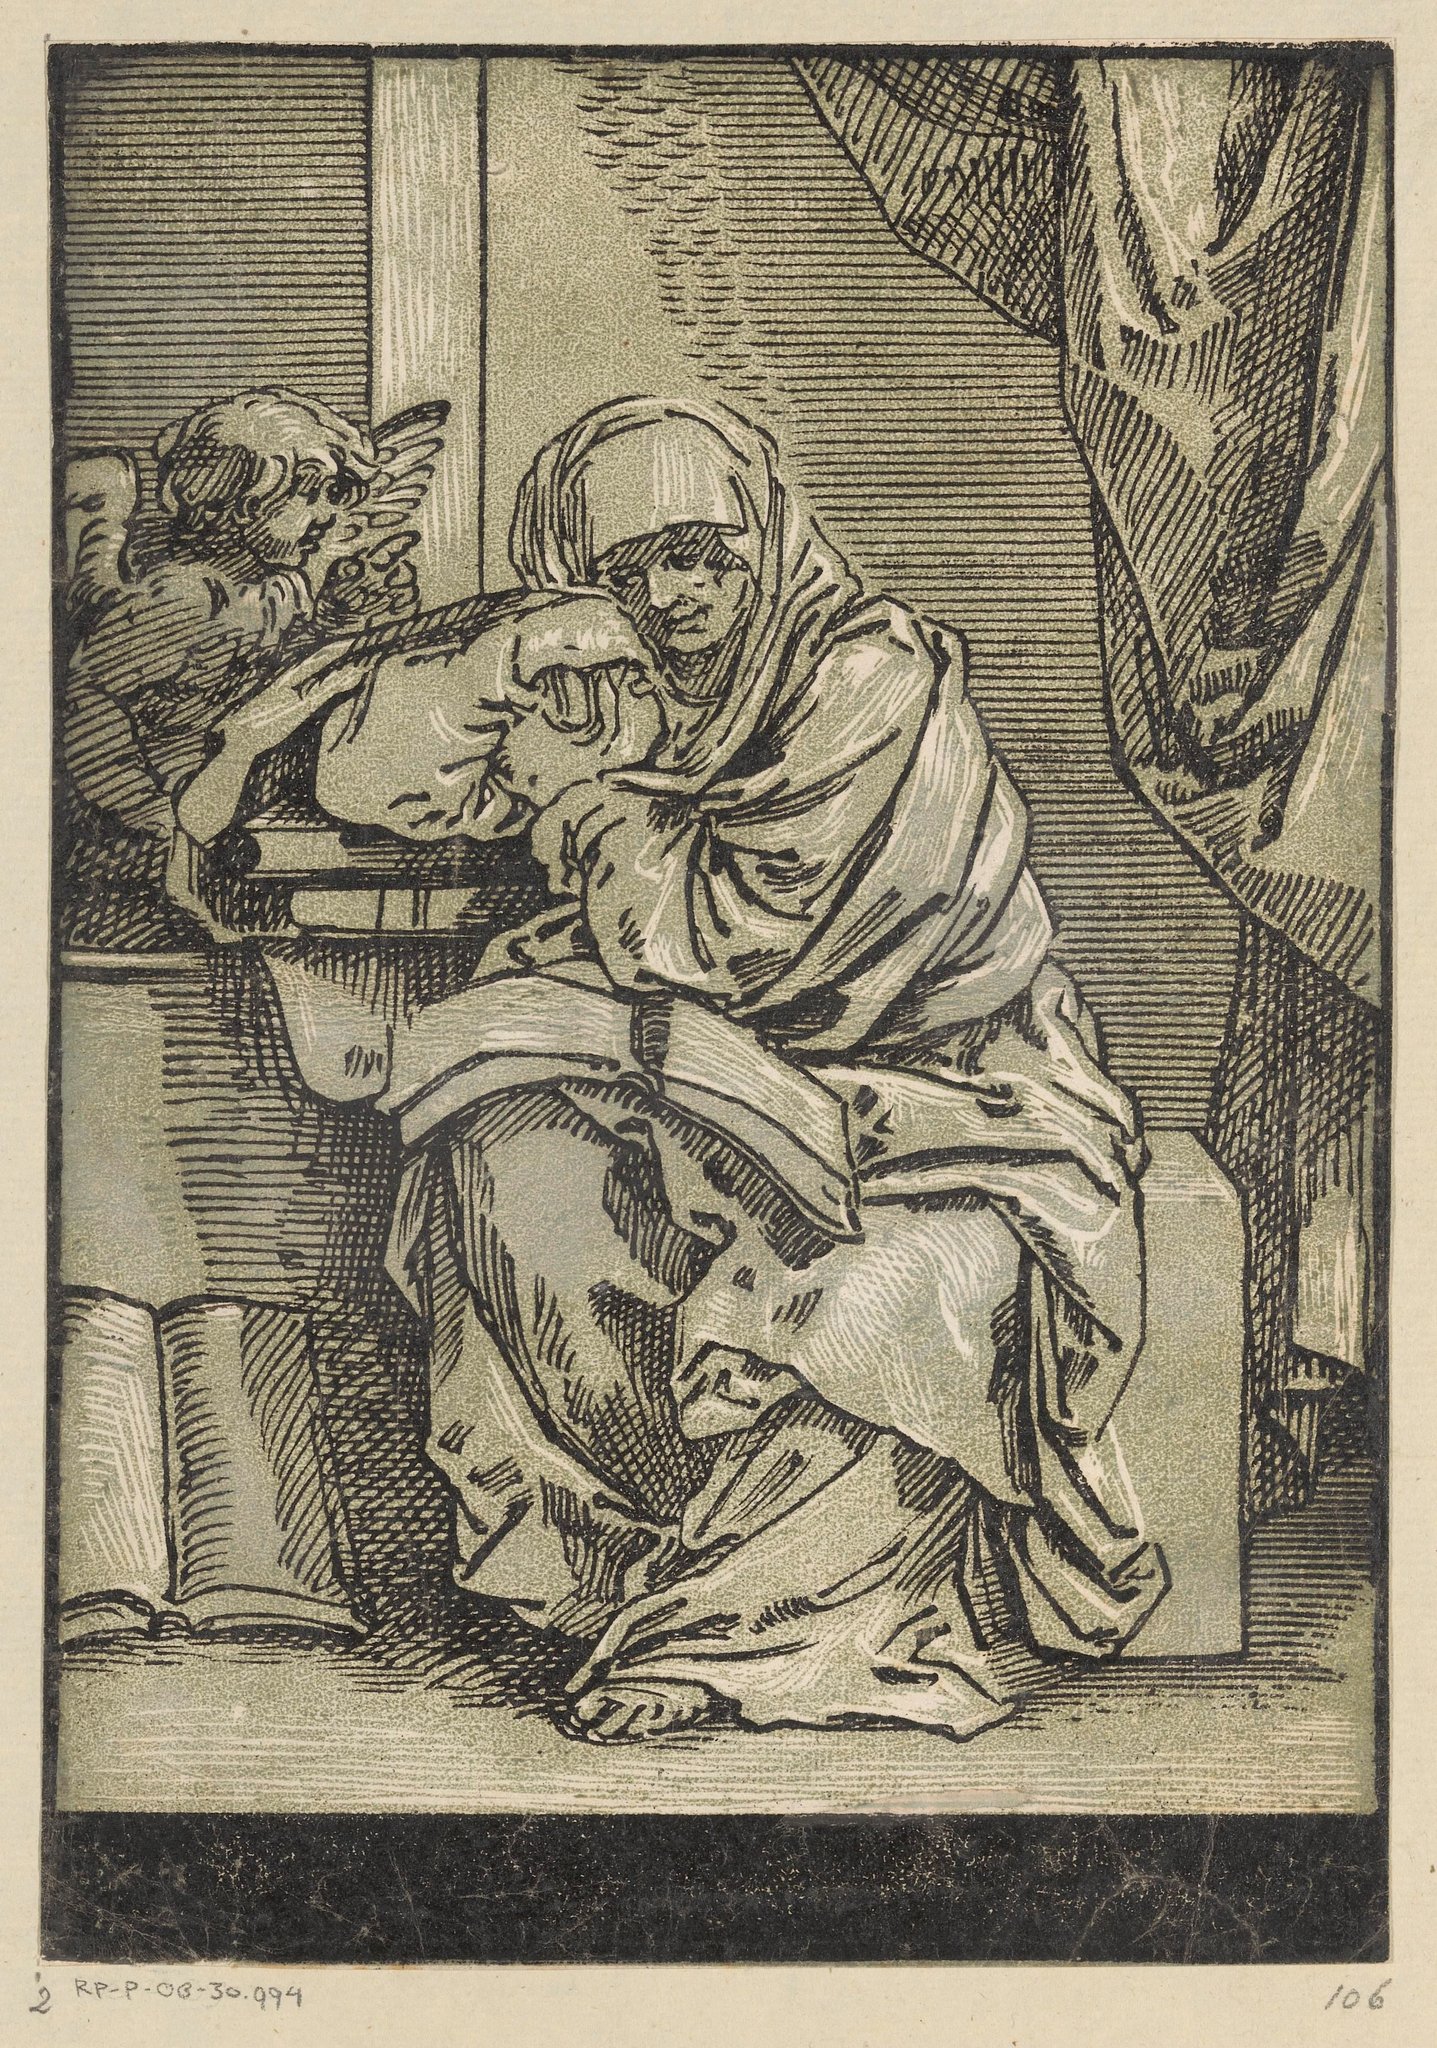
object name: print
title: Sibille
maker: bartolommeo coriolano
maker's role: print maker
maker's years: 1599-1676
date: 1609-1676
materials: paper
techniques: woodcut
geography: italy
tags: head held in the hand(s), with elbows leaning on an elevation or on the knees, sibyls (+ angel(s))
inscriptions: collector's mark: Lugt 240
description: Een sibille, zittend met het hoofd rustend op haar hand en met een boek op haar schoot. Links boeken en een engel.